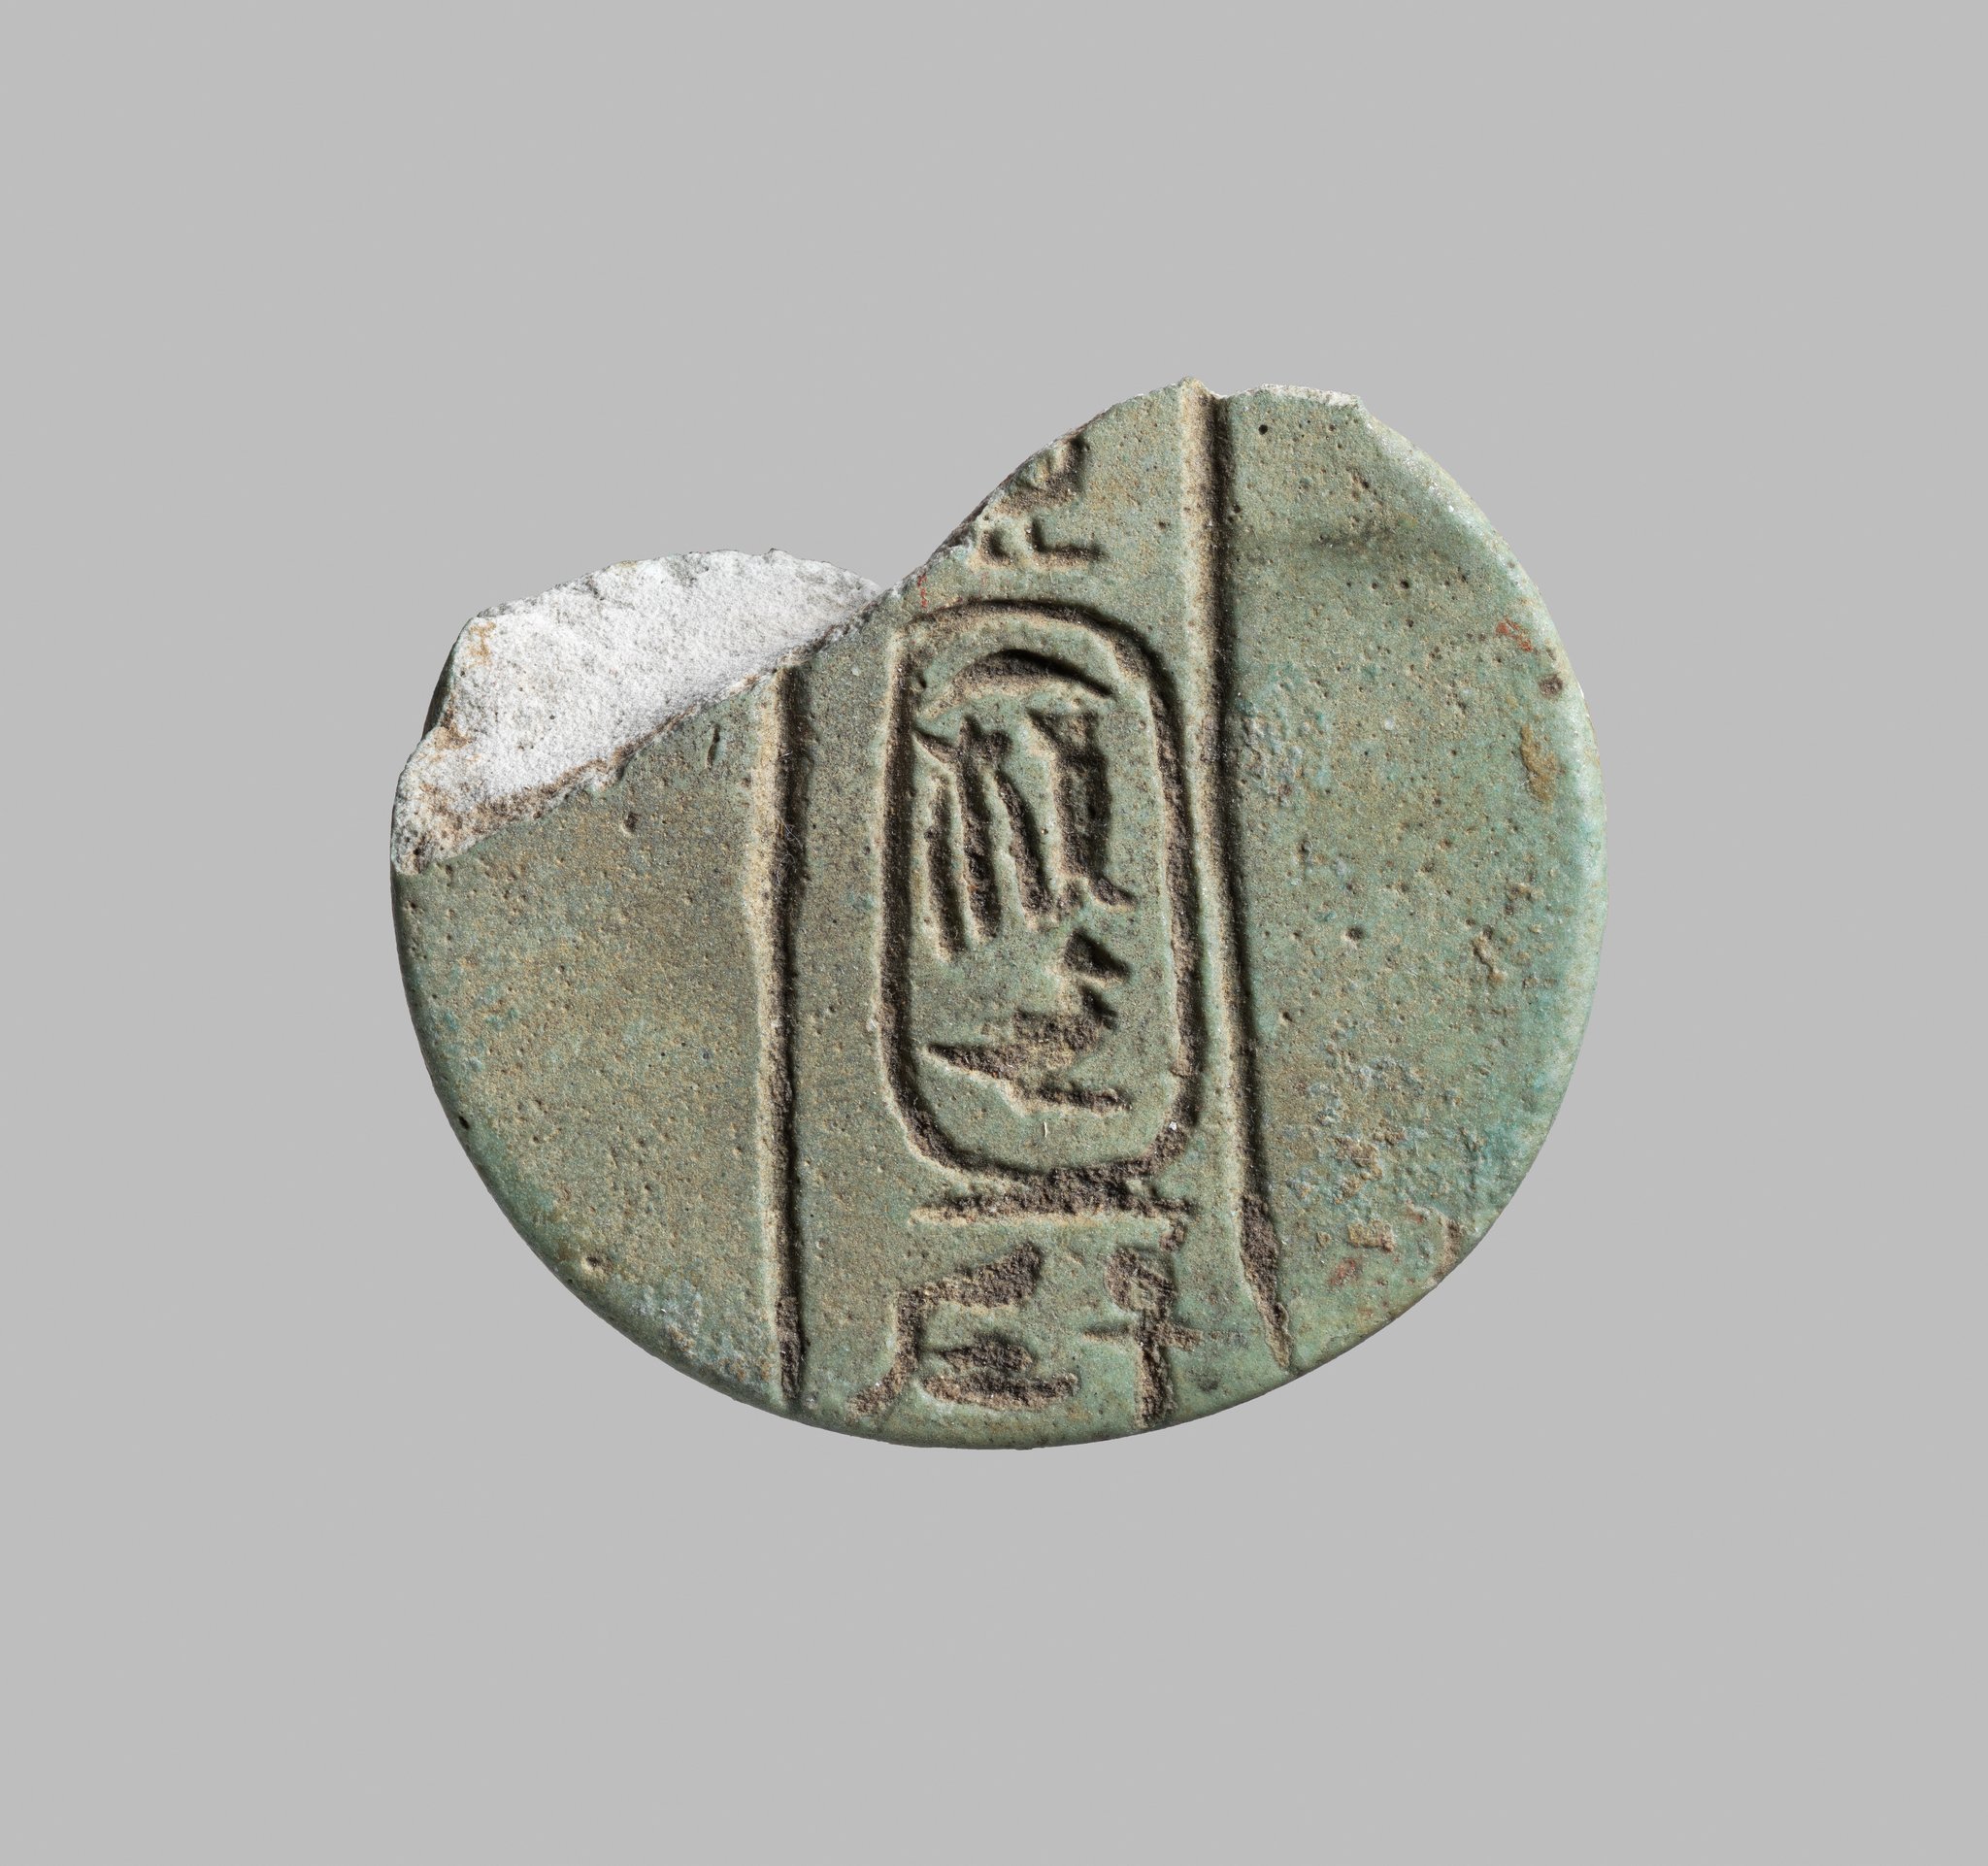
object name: menat fragment, amasis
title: Menat fragment with the name of Amasis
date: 570-526 BCE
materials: faience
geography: egypt